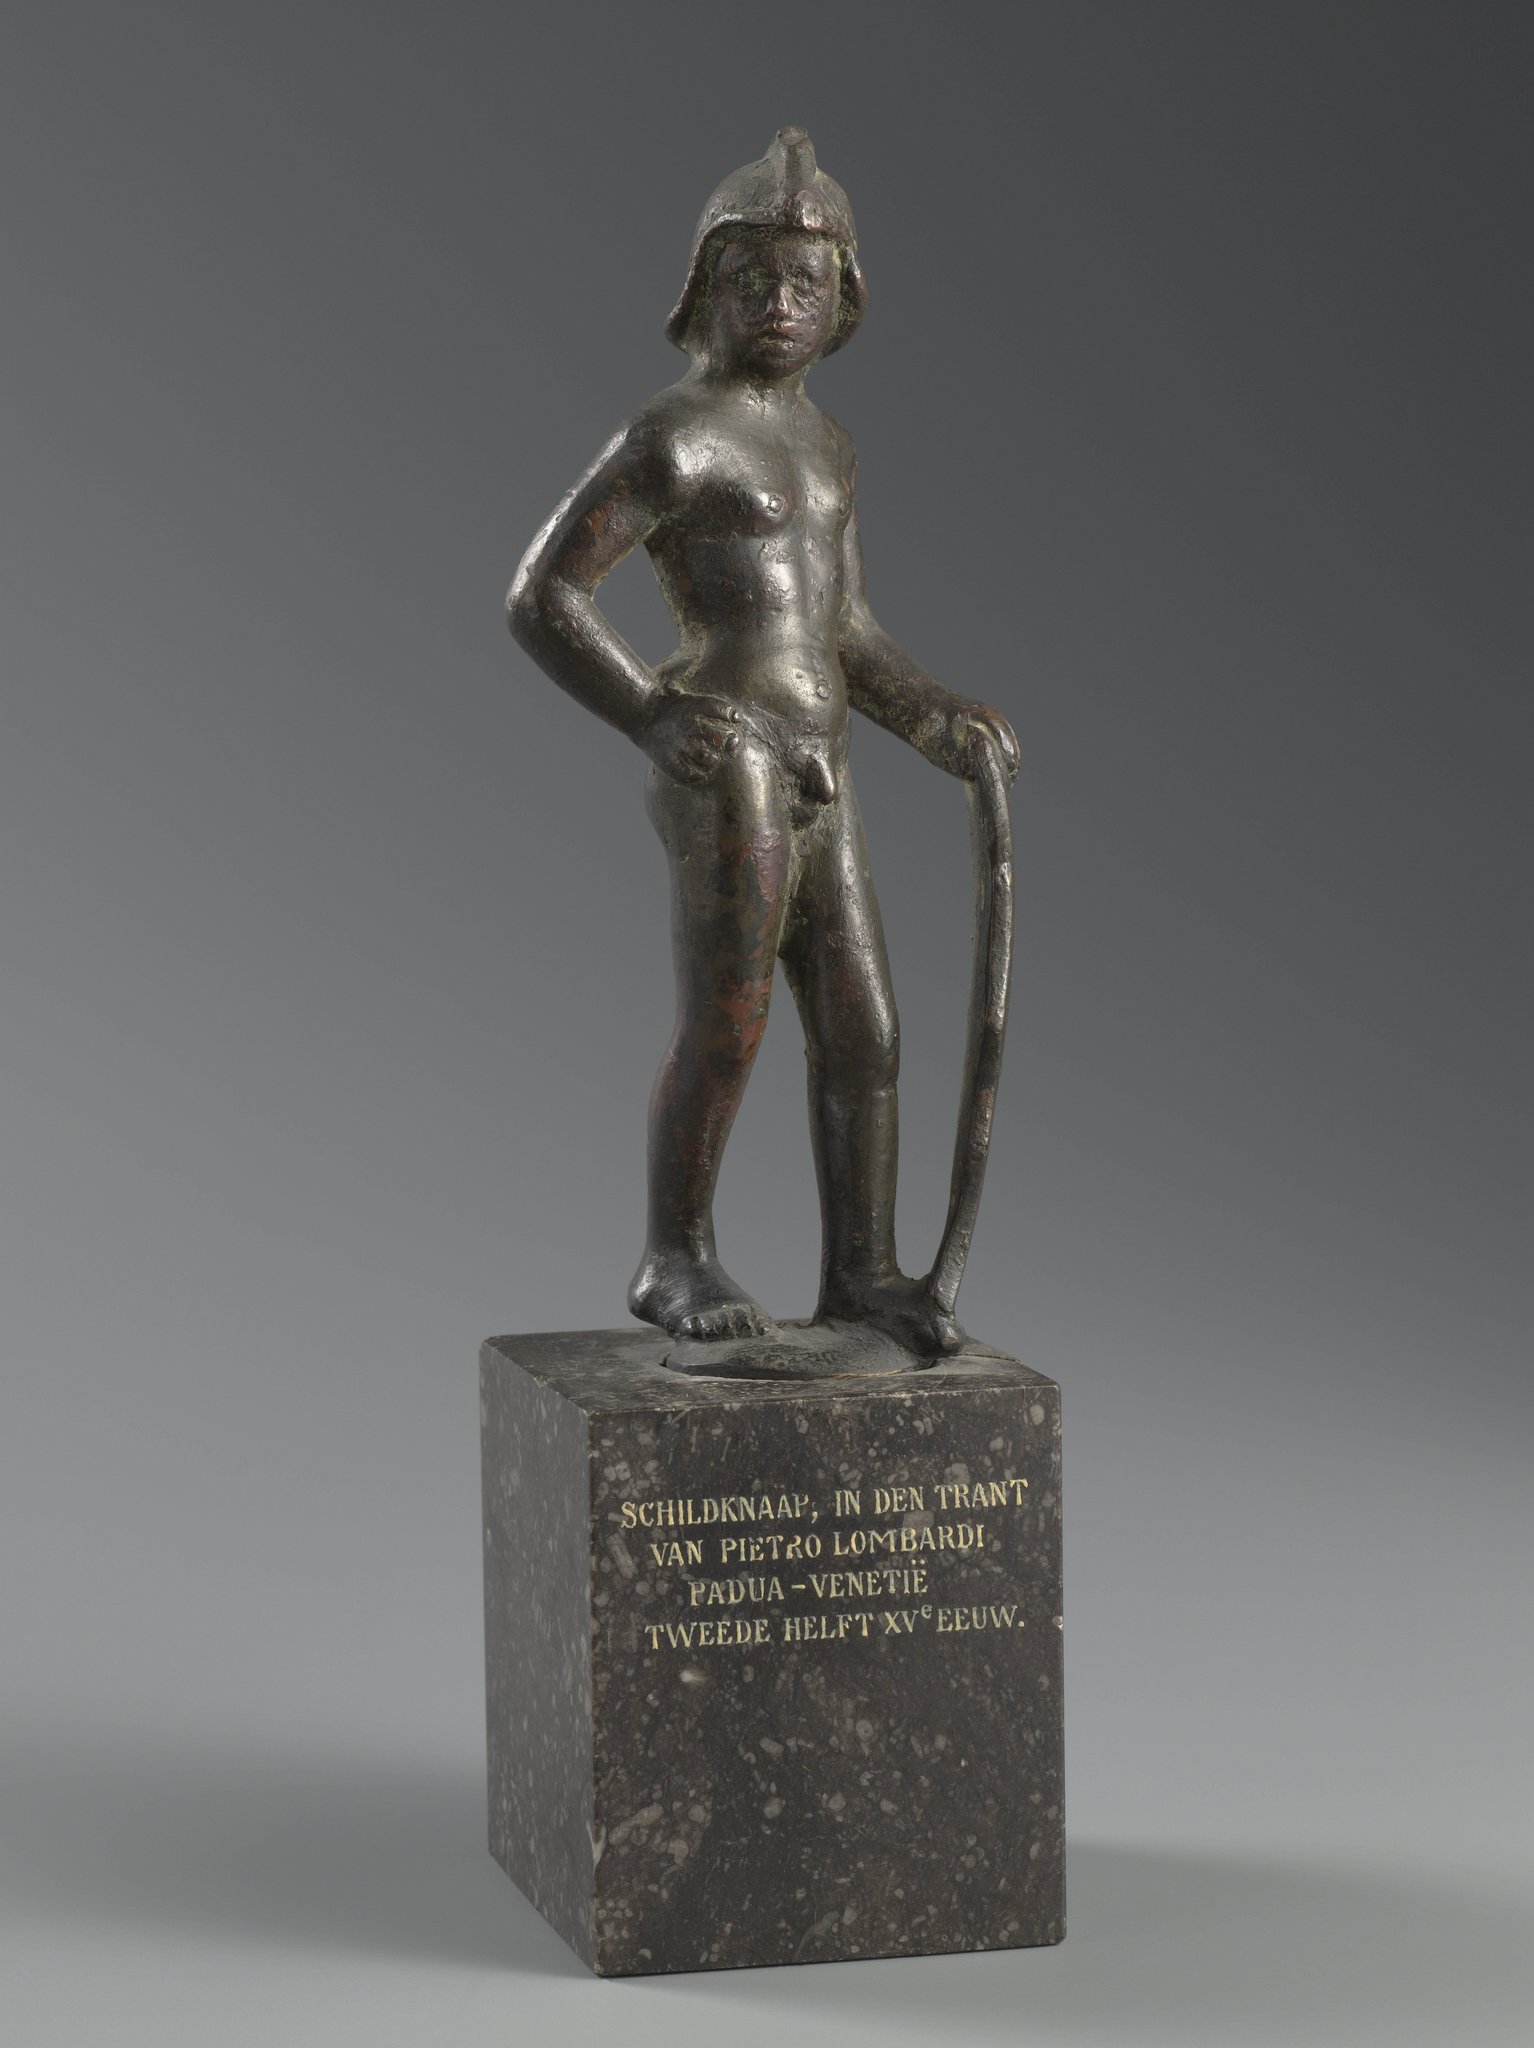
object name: sculpture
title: Schildknaap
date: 1475-1500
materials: bronze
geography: padua